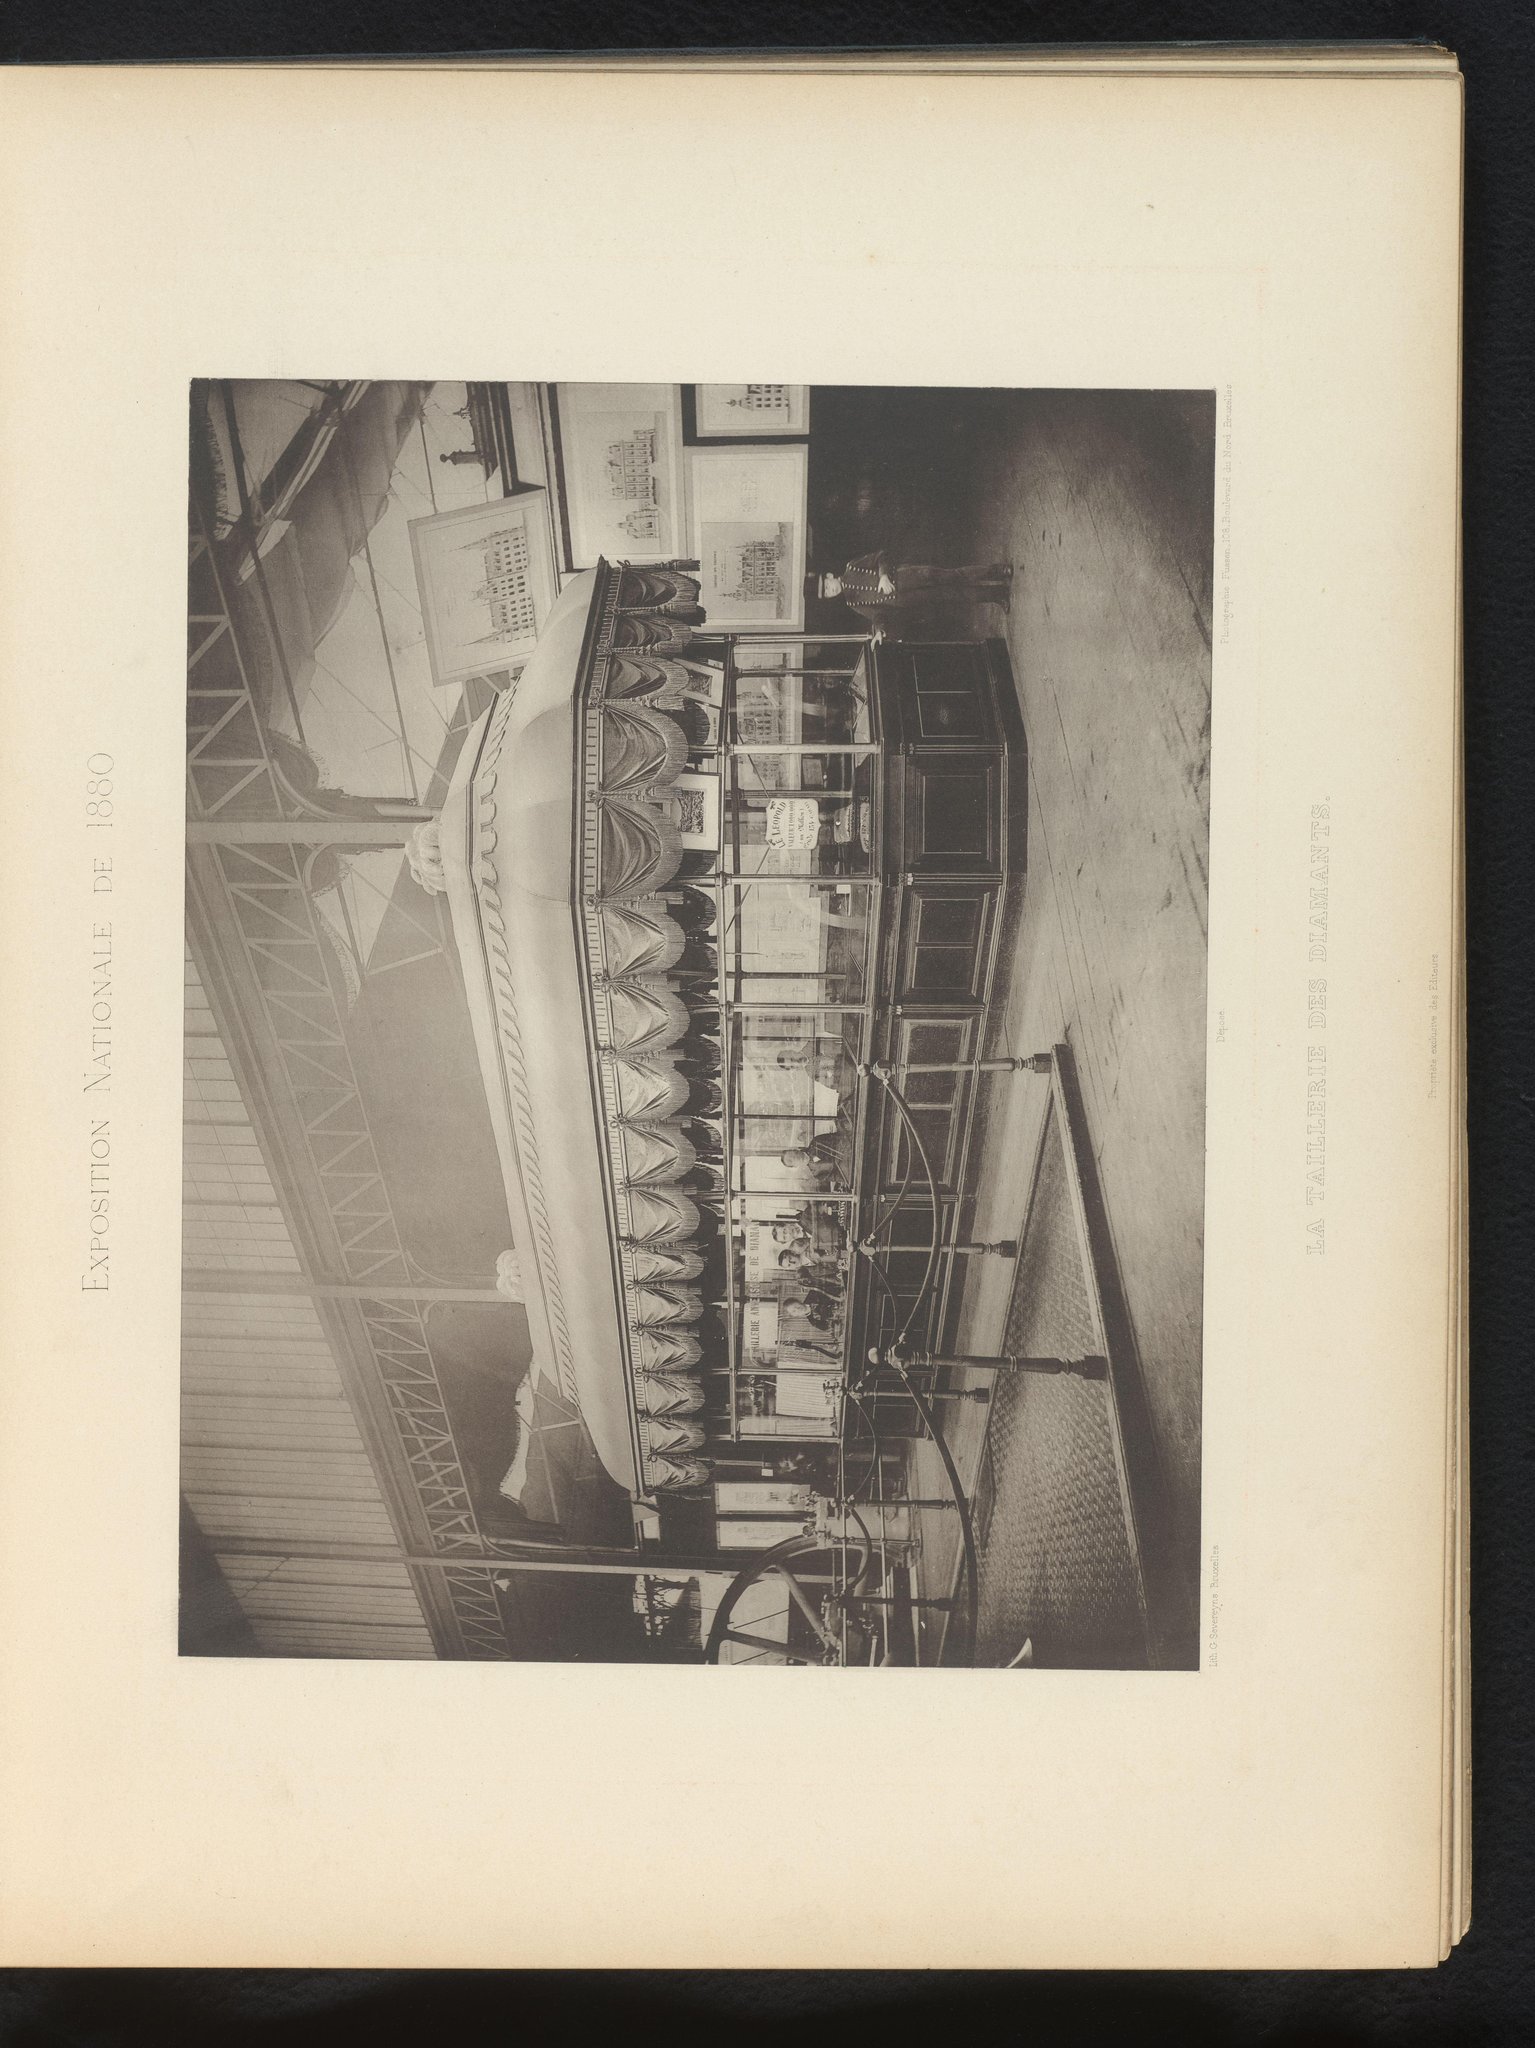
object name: page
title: Diamantslijperij op de Exposition Nationale van 1880 in Brussel, België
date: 1880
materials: paper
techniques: photograph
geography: brussels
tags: diamond polisher, diamond cutter, trade exhibition, industries fair, brussels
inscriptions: address: ‘Photographie Fussen, 108, Boulevard du Nord, Bruxelles.’, inscription: ‘Déposé.’, inscription: ‘Proprieté exclusive des Editeurs.’